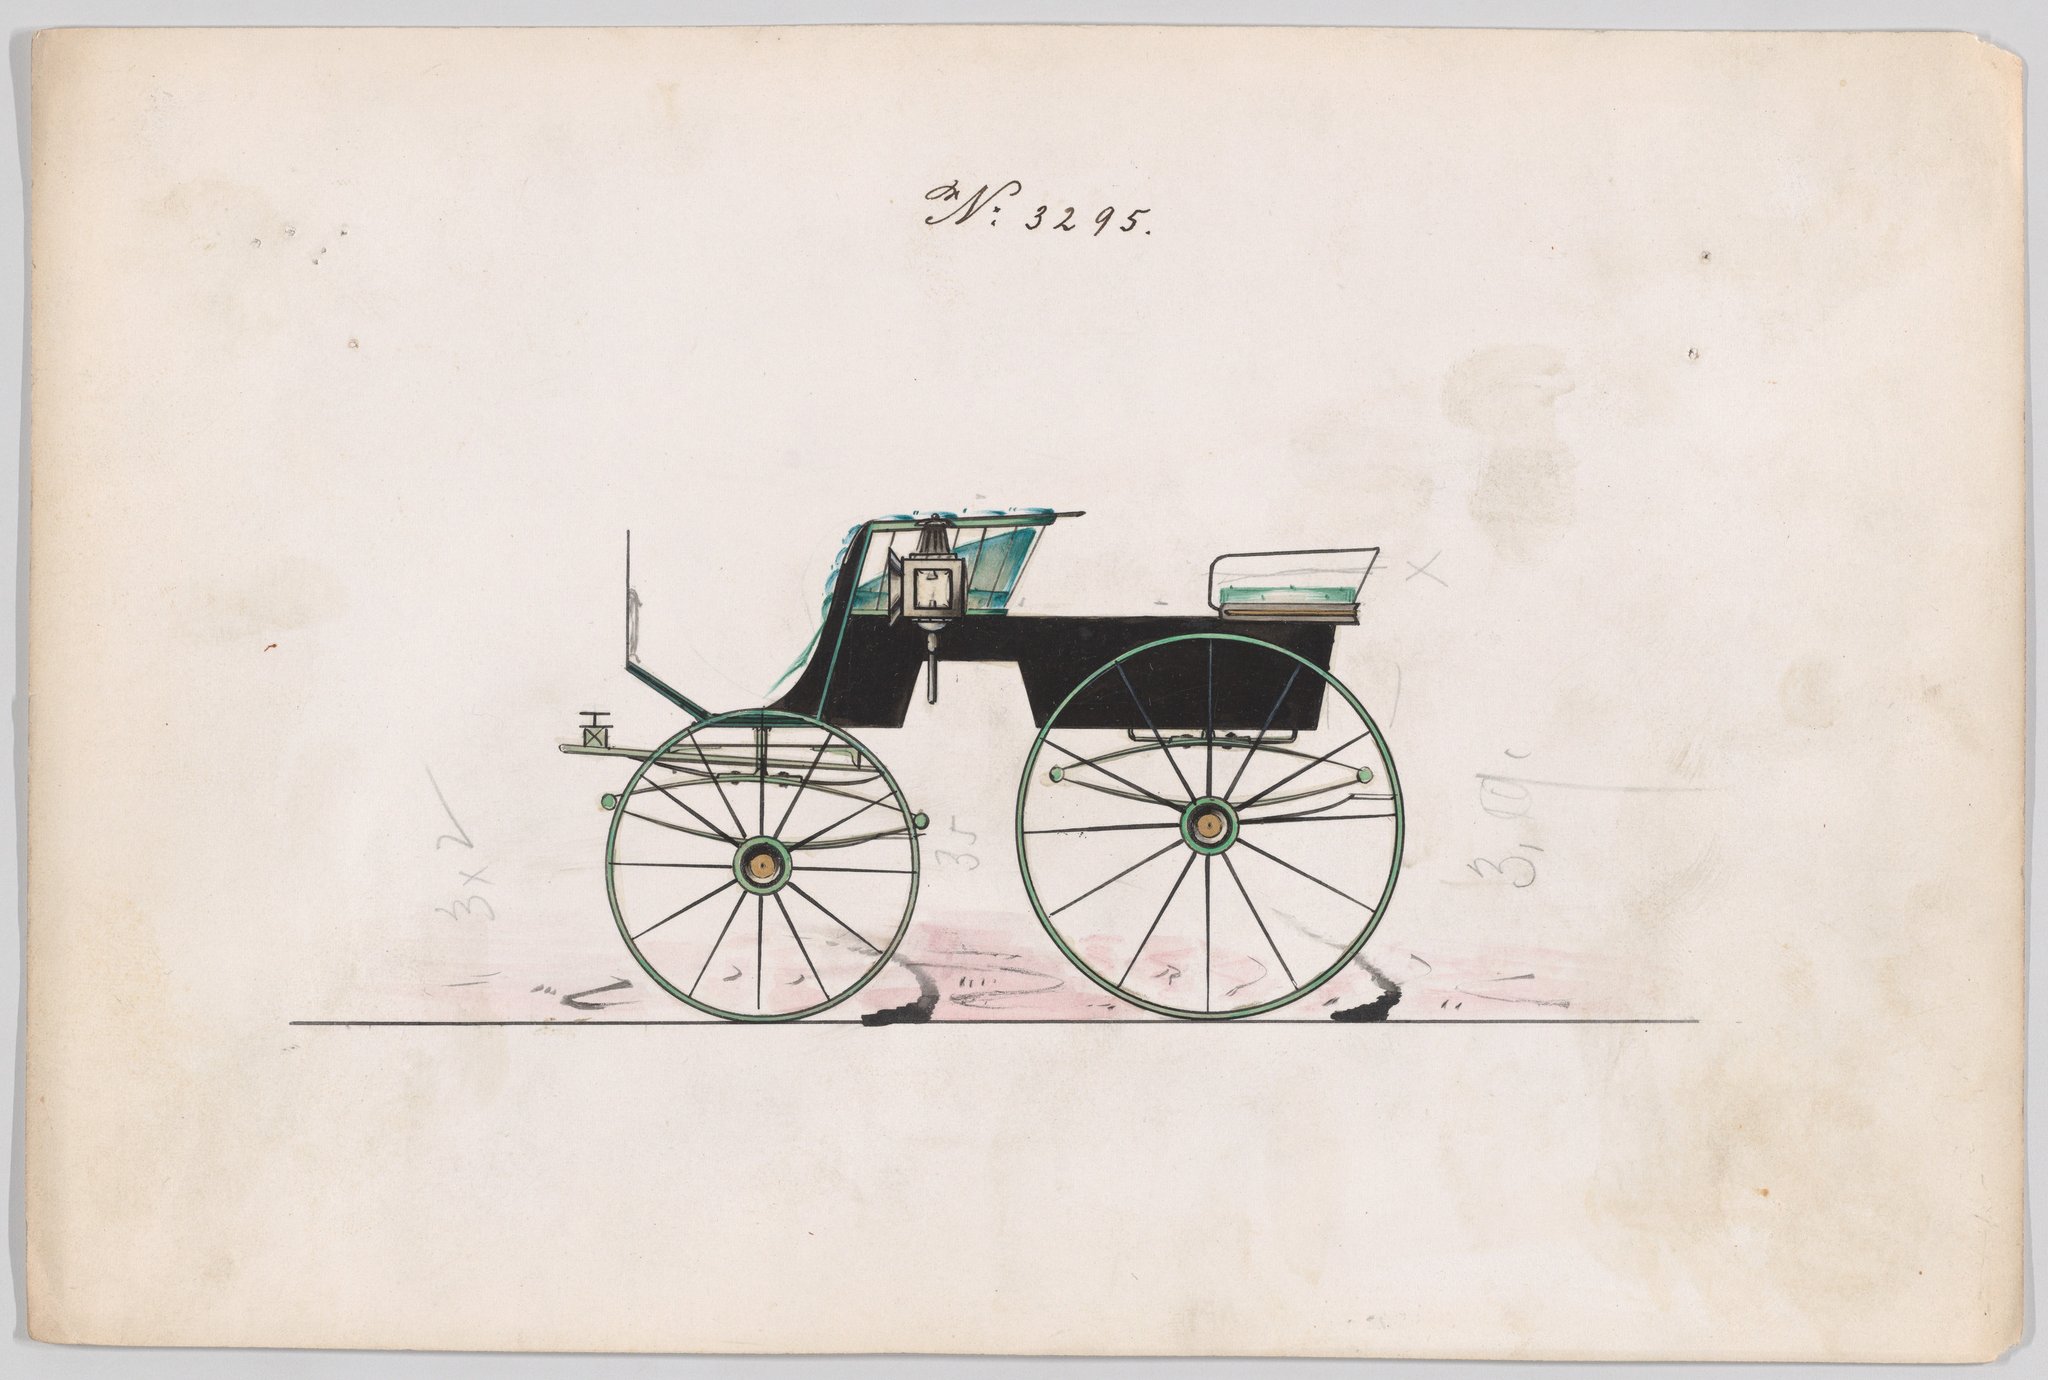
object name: drawing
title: T-Cart Phaeton #3295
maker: brewster & co.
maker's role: manufacturer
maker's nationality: american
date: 1878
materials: gouache, gum arabic, ink, watercolor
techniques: pen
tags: carriages